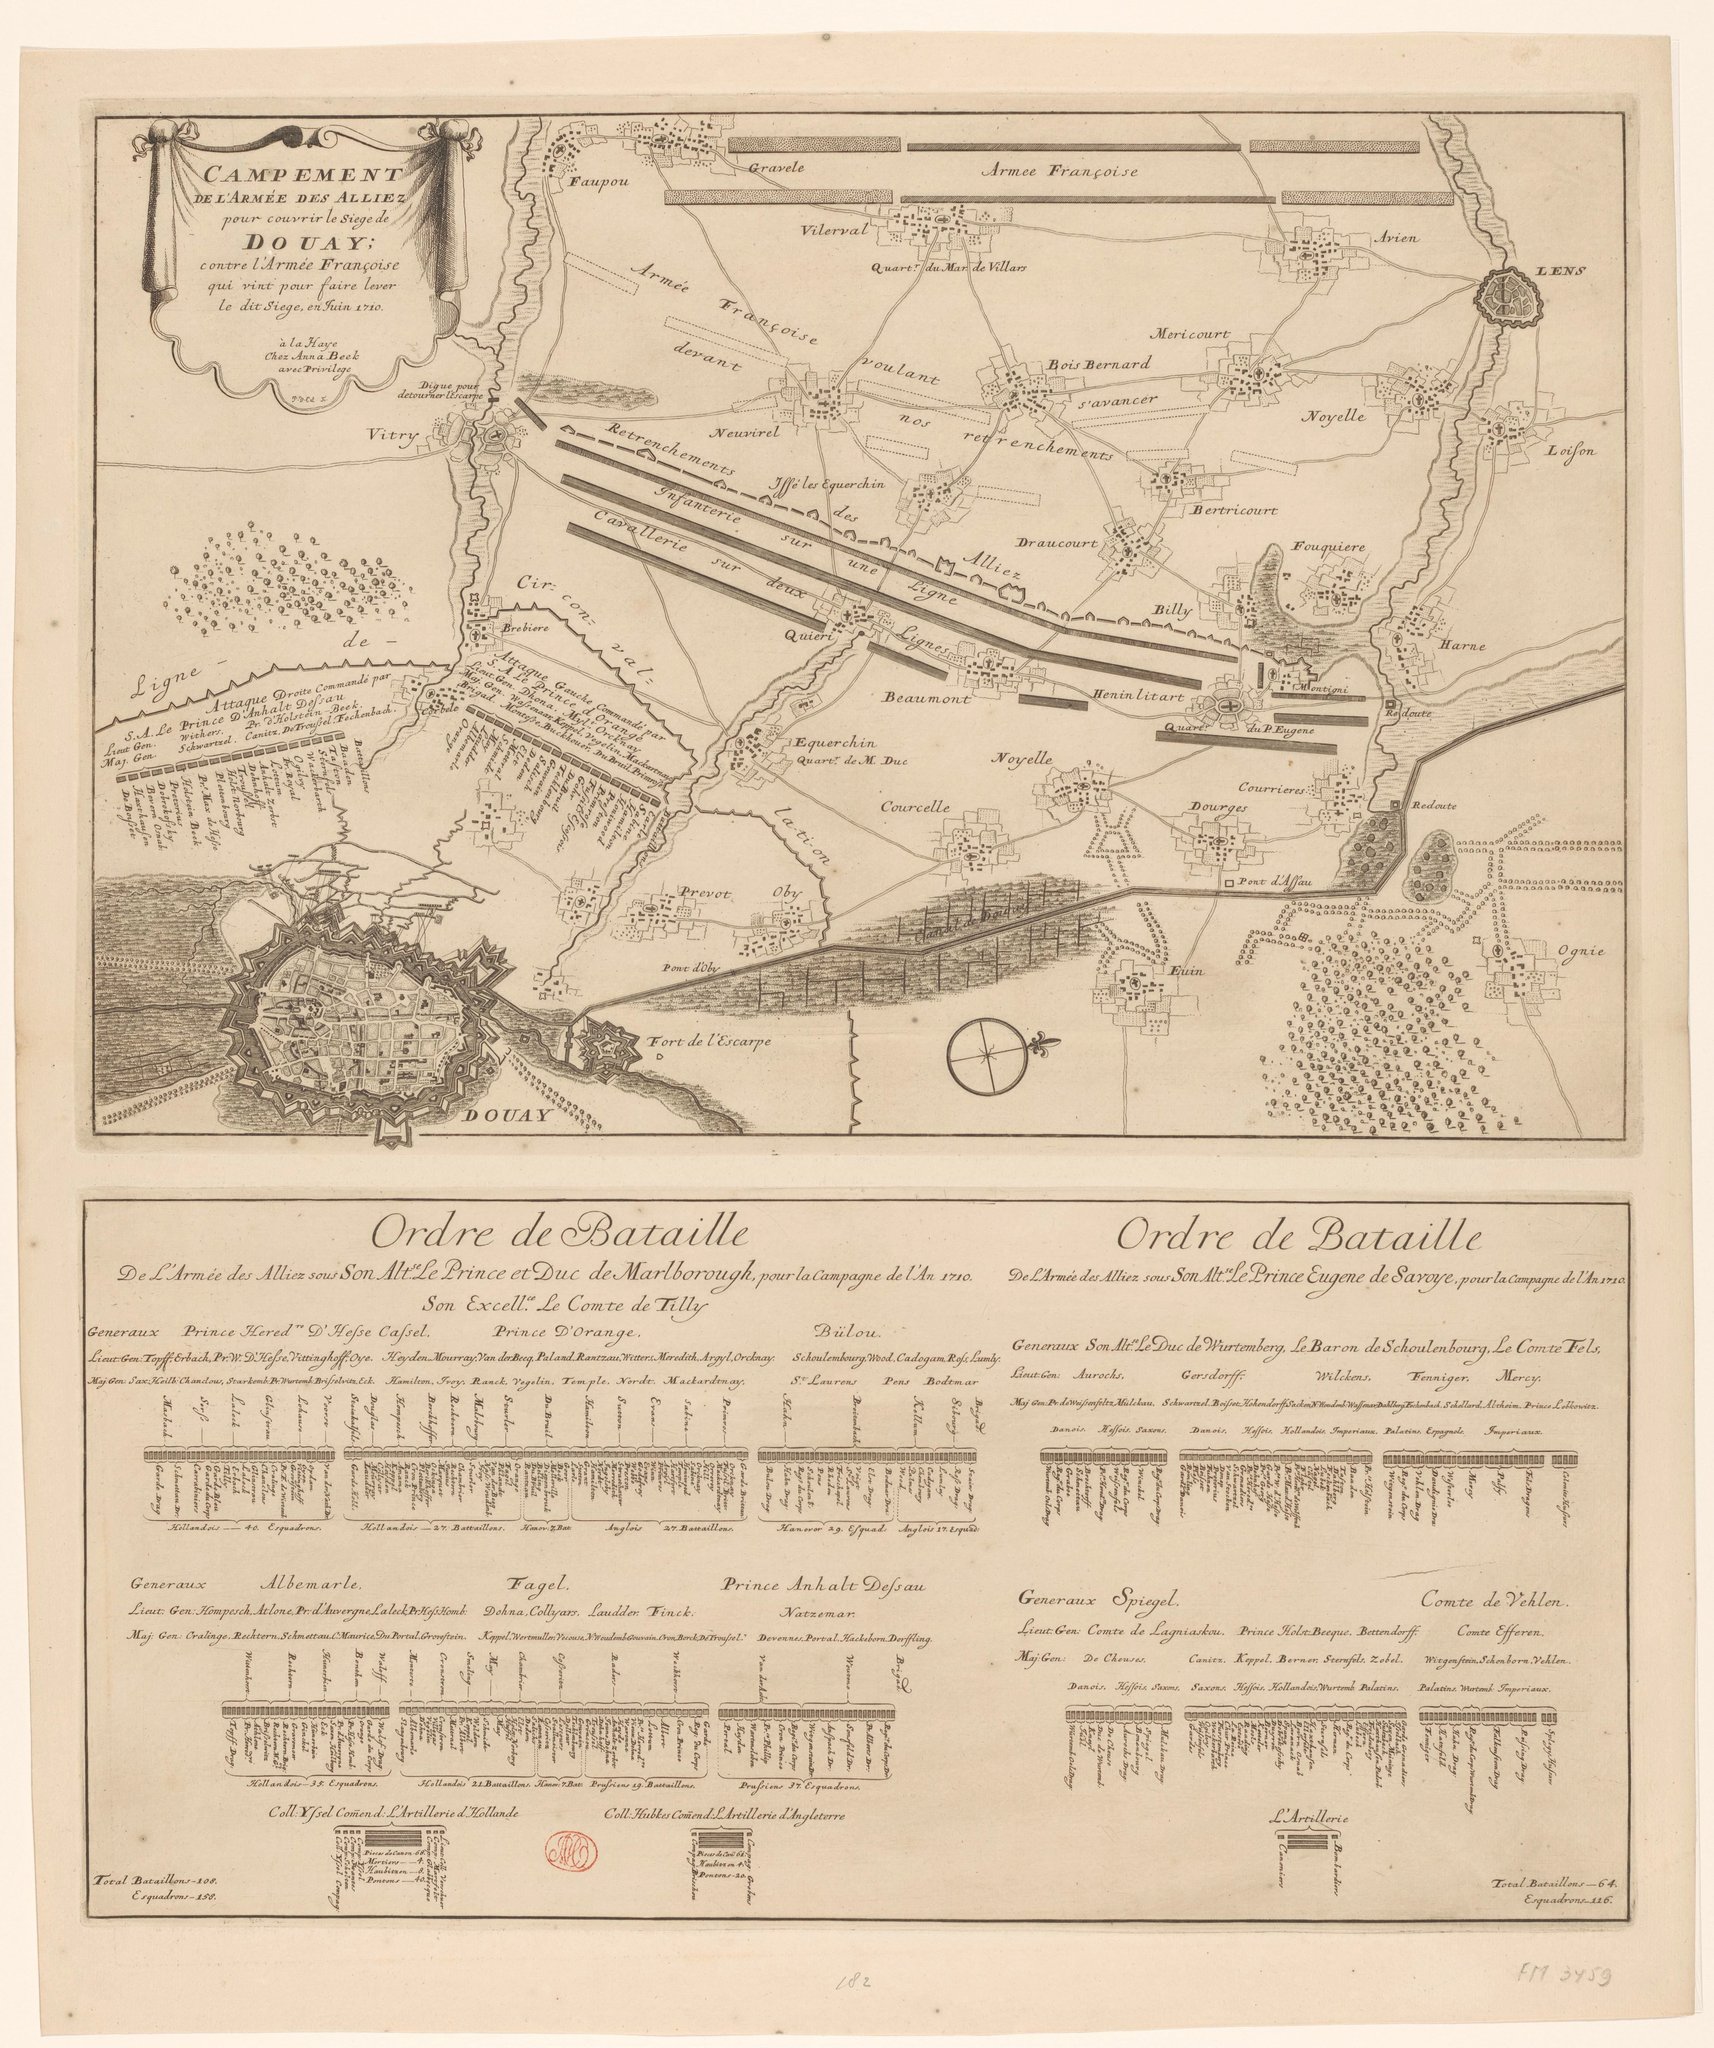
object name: print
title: Campement de l'armée des Alliez pour couvrir le siege de Douay contre l'armée Françoise qui vint pour faire lever le dit siege, en Juin 1710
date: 1710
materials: paper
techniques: etching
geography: the hague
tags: johan willem friso (prins van oranje-nassau), paris, vienna, eugenius van savoye, john churchill (1e hertog van marlborough), maps of separate countries or regions, siege, position war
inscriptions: collector's mark: Lugt 2228, collector's mark: Lugt 195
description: In een latere staat gebruikt als illustratie in het tweede deel van: Mont, Jean du. Oorlogskundige beschryving van de veldslagen en belegeringen, der drie (...) wydvermaarde krygsoversten (...) den Prins Eugenius van Savoye, den (...) Hertog van Marlborough, en den Prins van Oranje en Nassau-Vriesland, in de editie van 1729; zie FMH 3032/II/43.